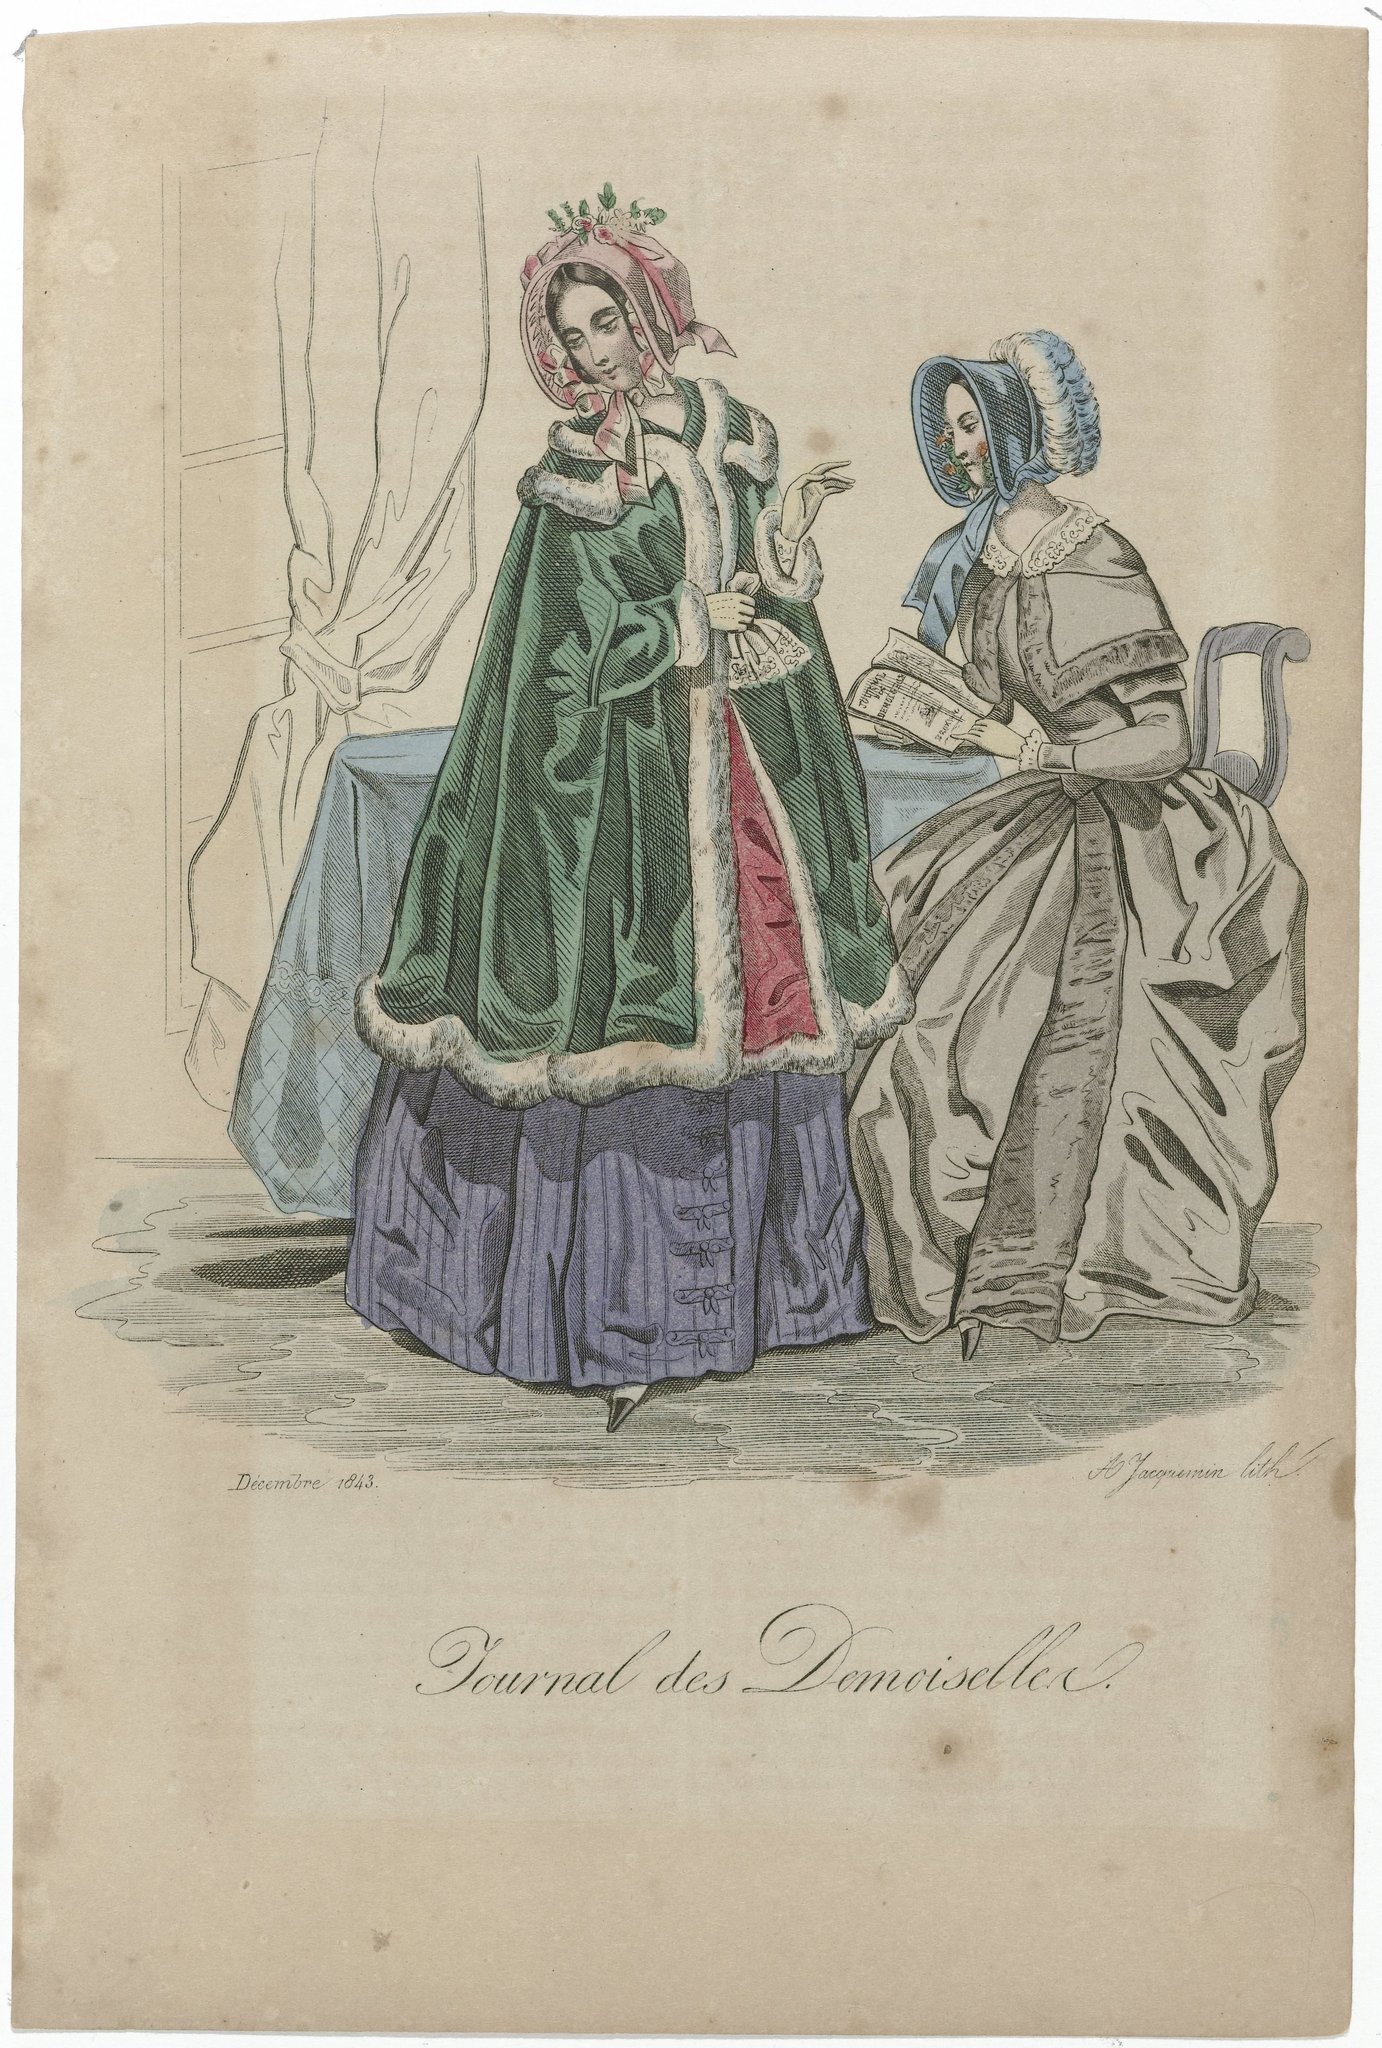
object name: fashion print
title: Journal des Demoiselles, décembre 1843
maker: jacquemin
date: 1843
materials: paper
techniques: hand coloring, lithograph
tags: handkerchief (+ women's clothes), coat (+ women's clothes), head-gear (+ women's clothes), fashion plates, skirt (+ women's clothes), dress, gown (+ women's clothes), book - mm - book open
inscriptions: title: ‘Journal des Demoiselles.’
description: Vrouw, zittend aan tafel, met het modetijdschrift 'Journal des Demoiselles' voor zich. Luifelhoed met struisveer. Prent uit het modetijdschrift Journal des Demoiselles (1833 -1922).